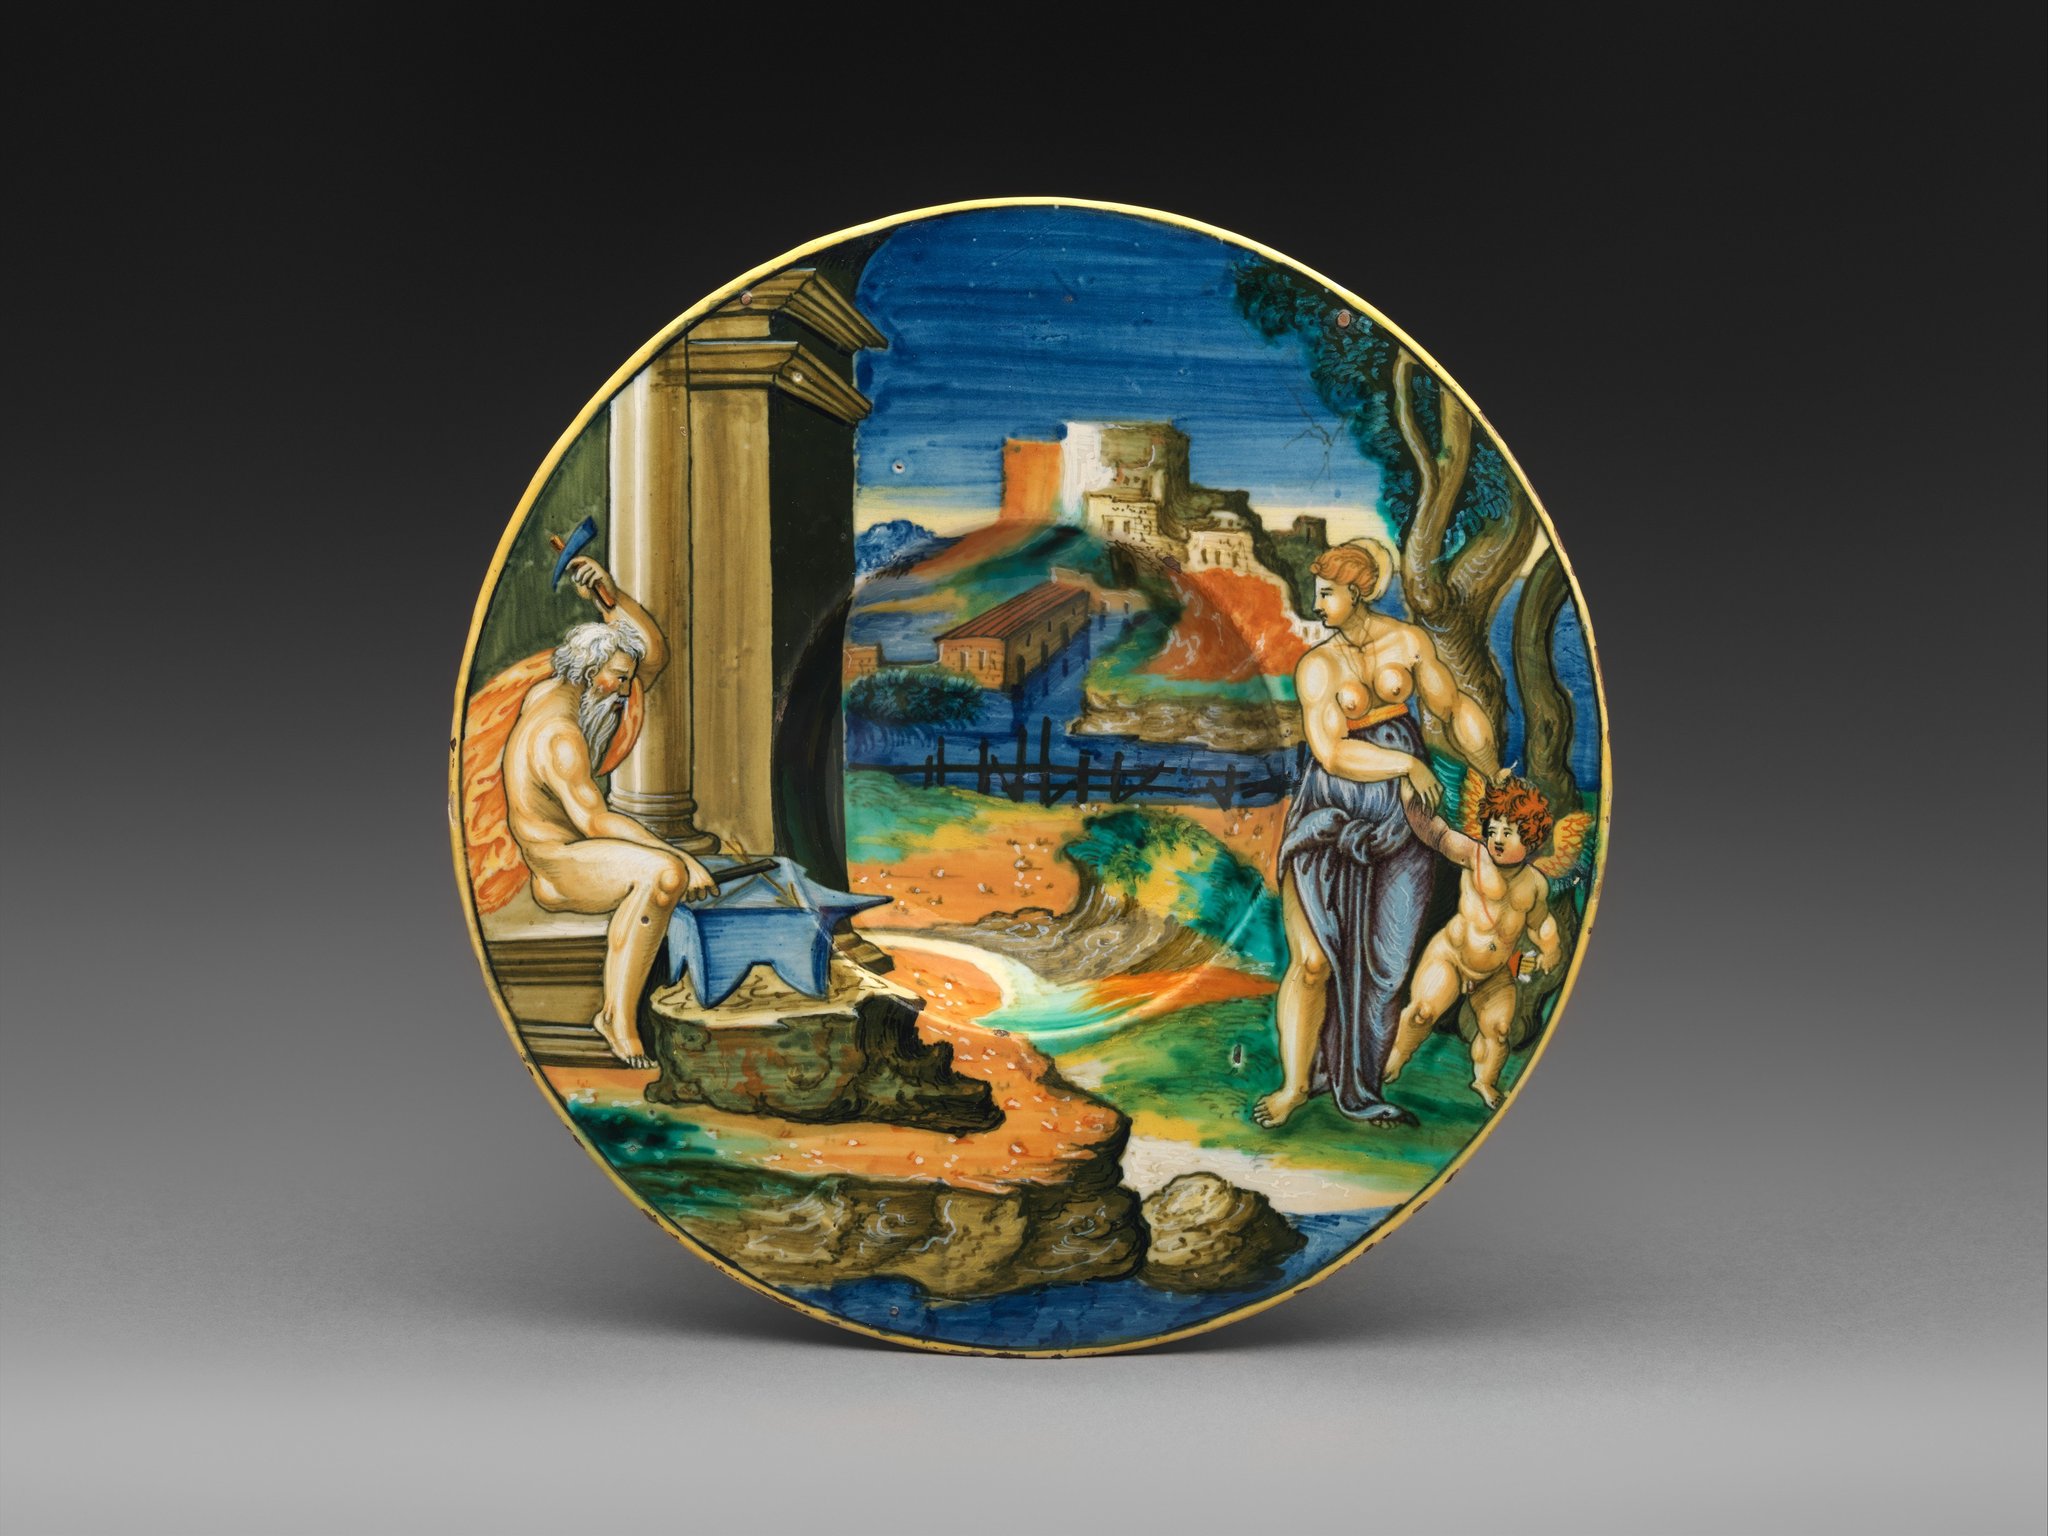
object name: bowl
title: Wide-rimmed bowl with Vulcan Forging Arms with Venus and Cupid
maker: fra xanto avelli da rovigo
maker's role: artist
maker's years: 1486-1582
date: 1528-1530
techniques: maiolica, glazing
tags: cupid,venus,vulcan